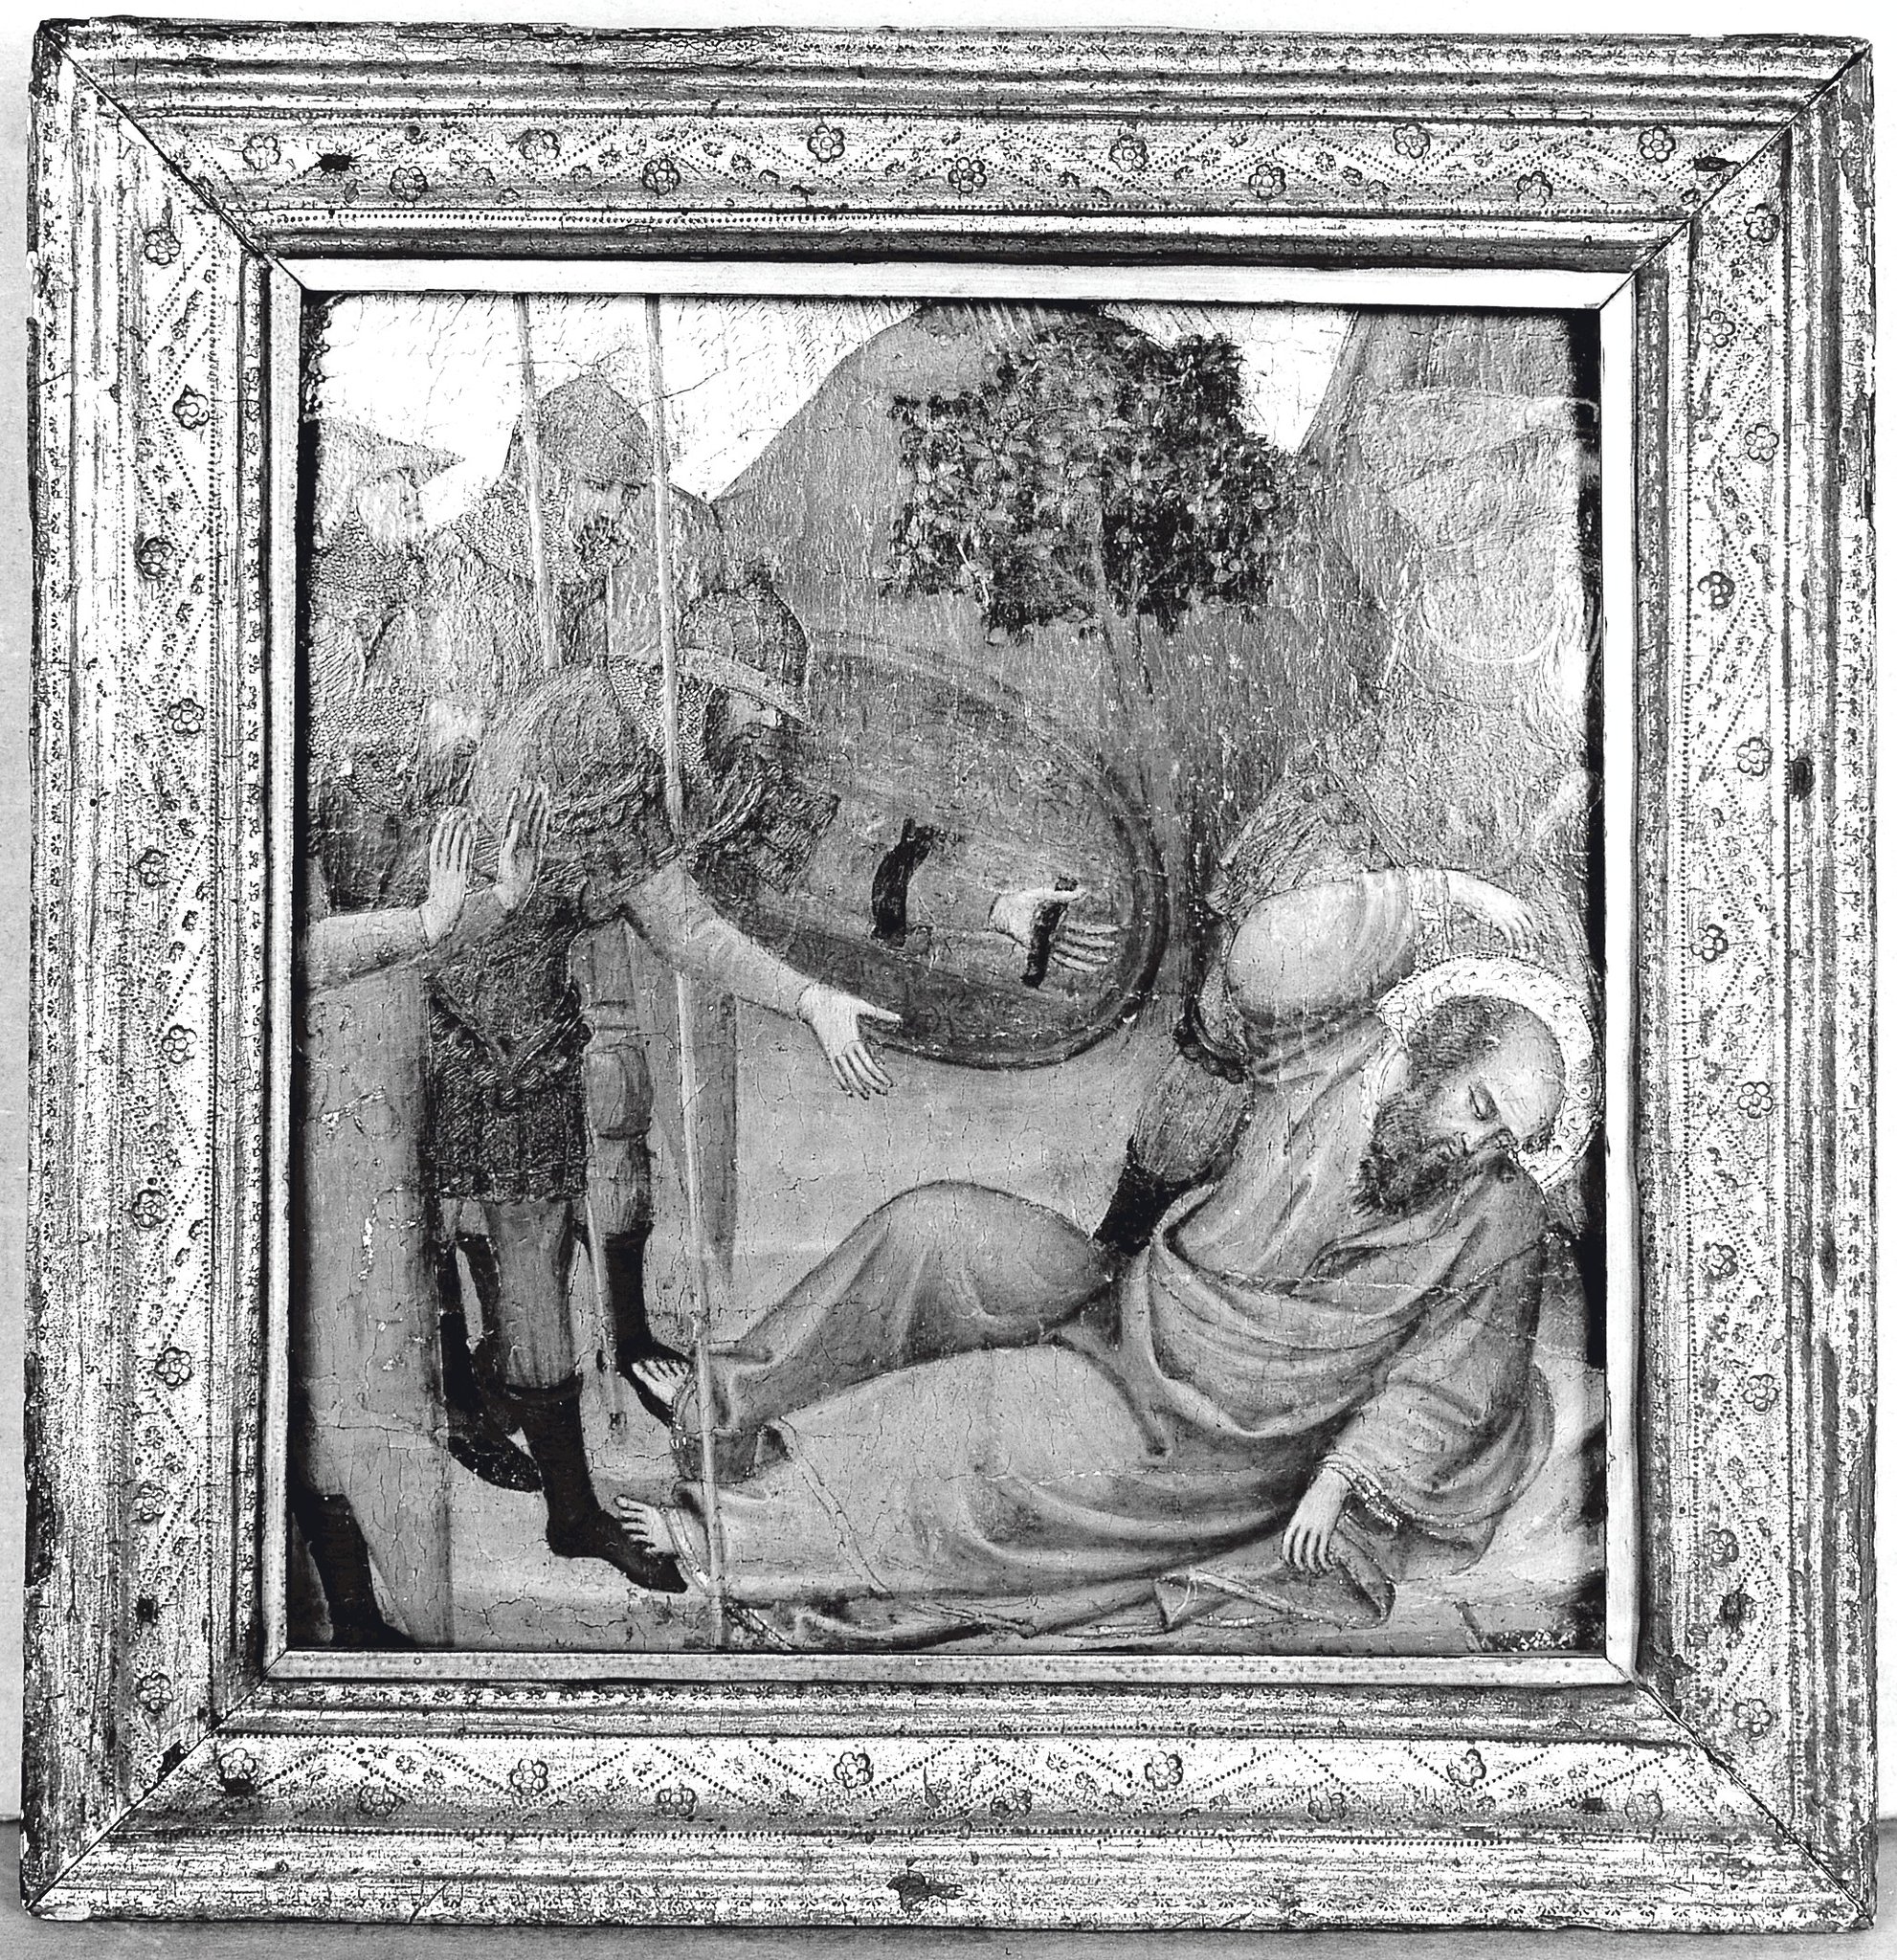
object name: frame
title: Cassetta Frame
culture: italian, veneto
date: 1534-1566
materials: wood